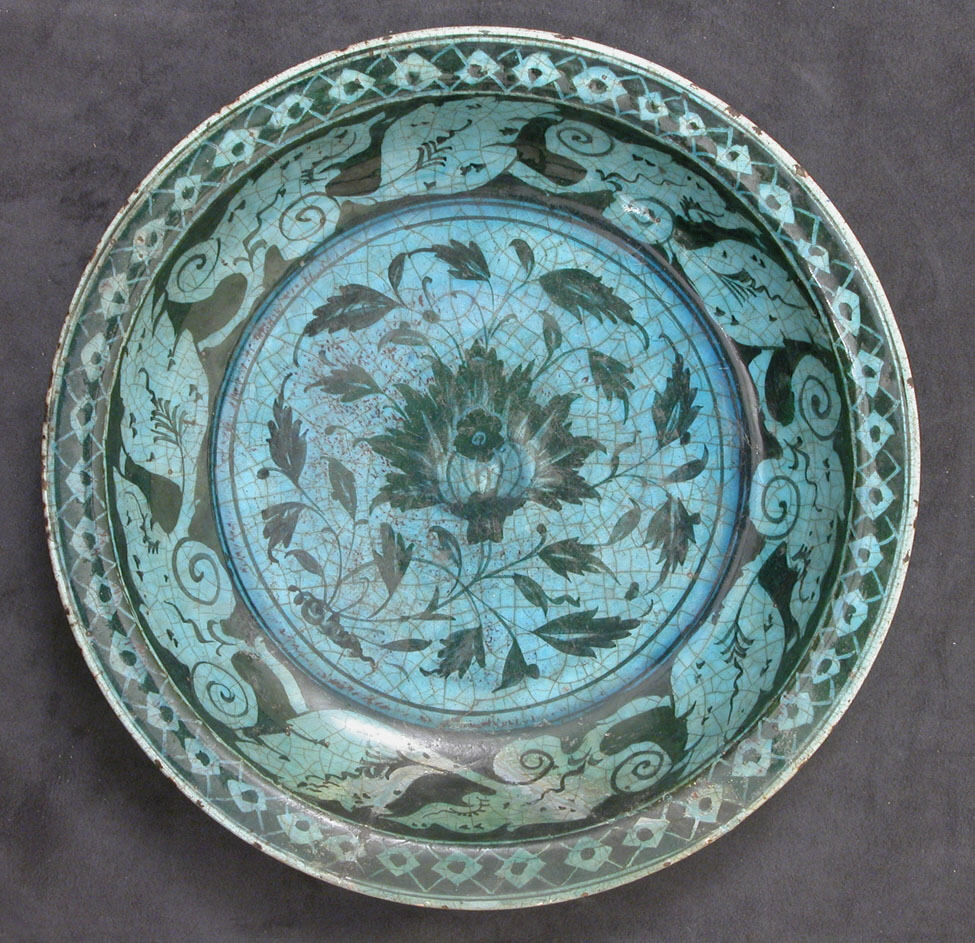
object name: bowl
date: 1501-1700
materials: glaze, stonepaste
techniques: painting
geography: iran